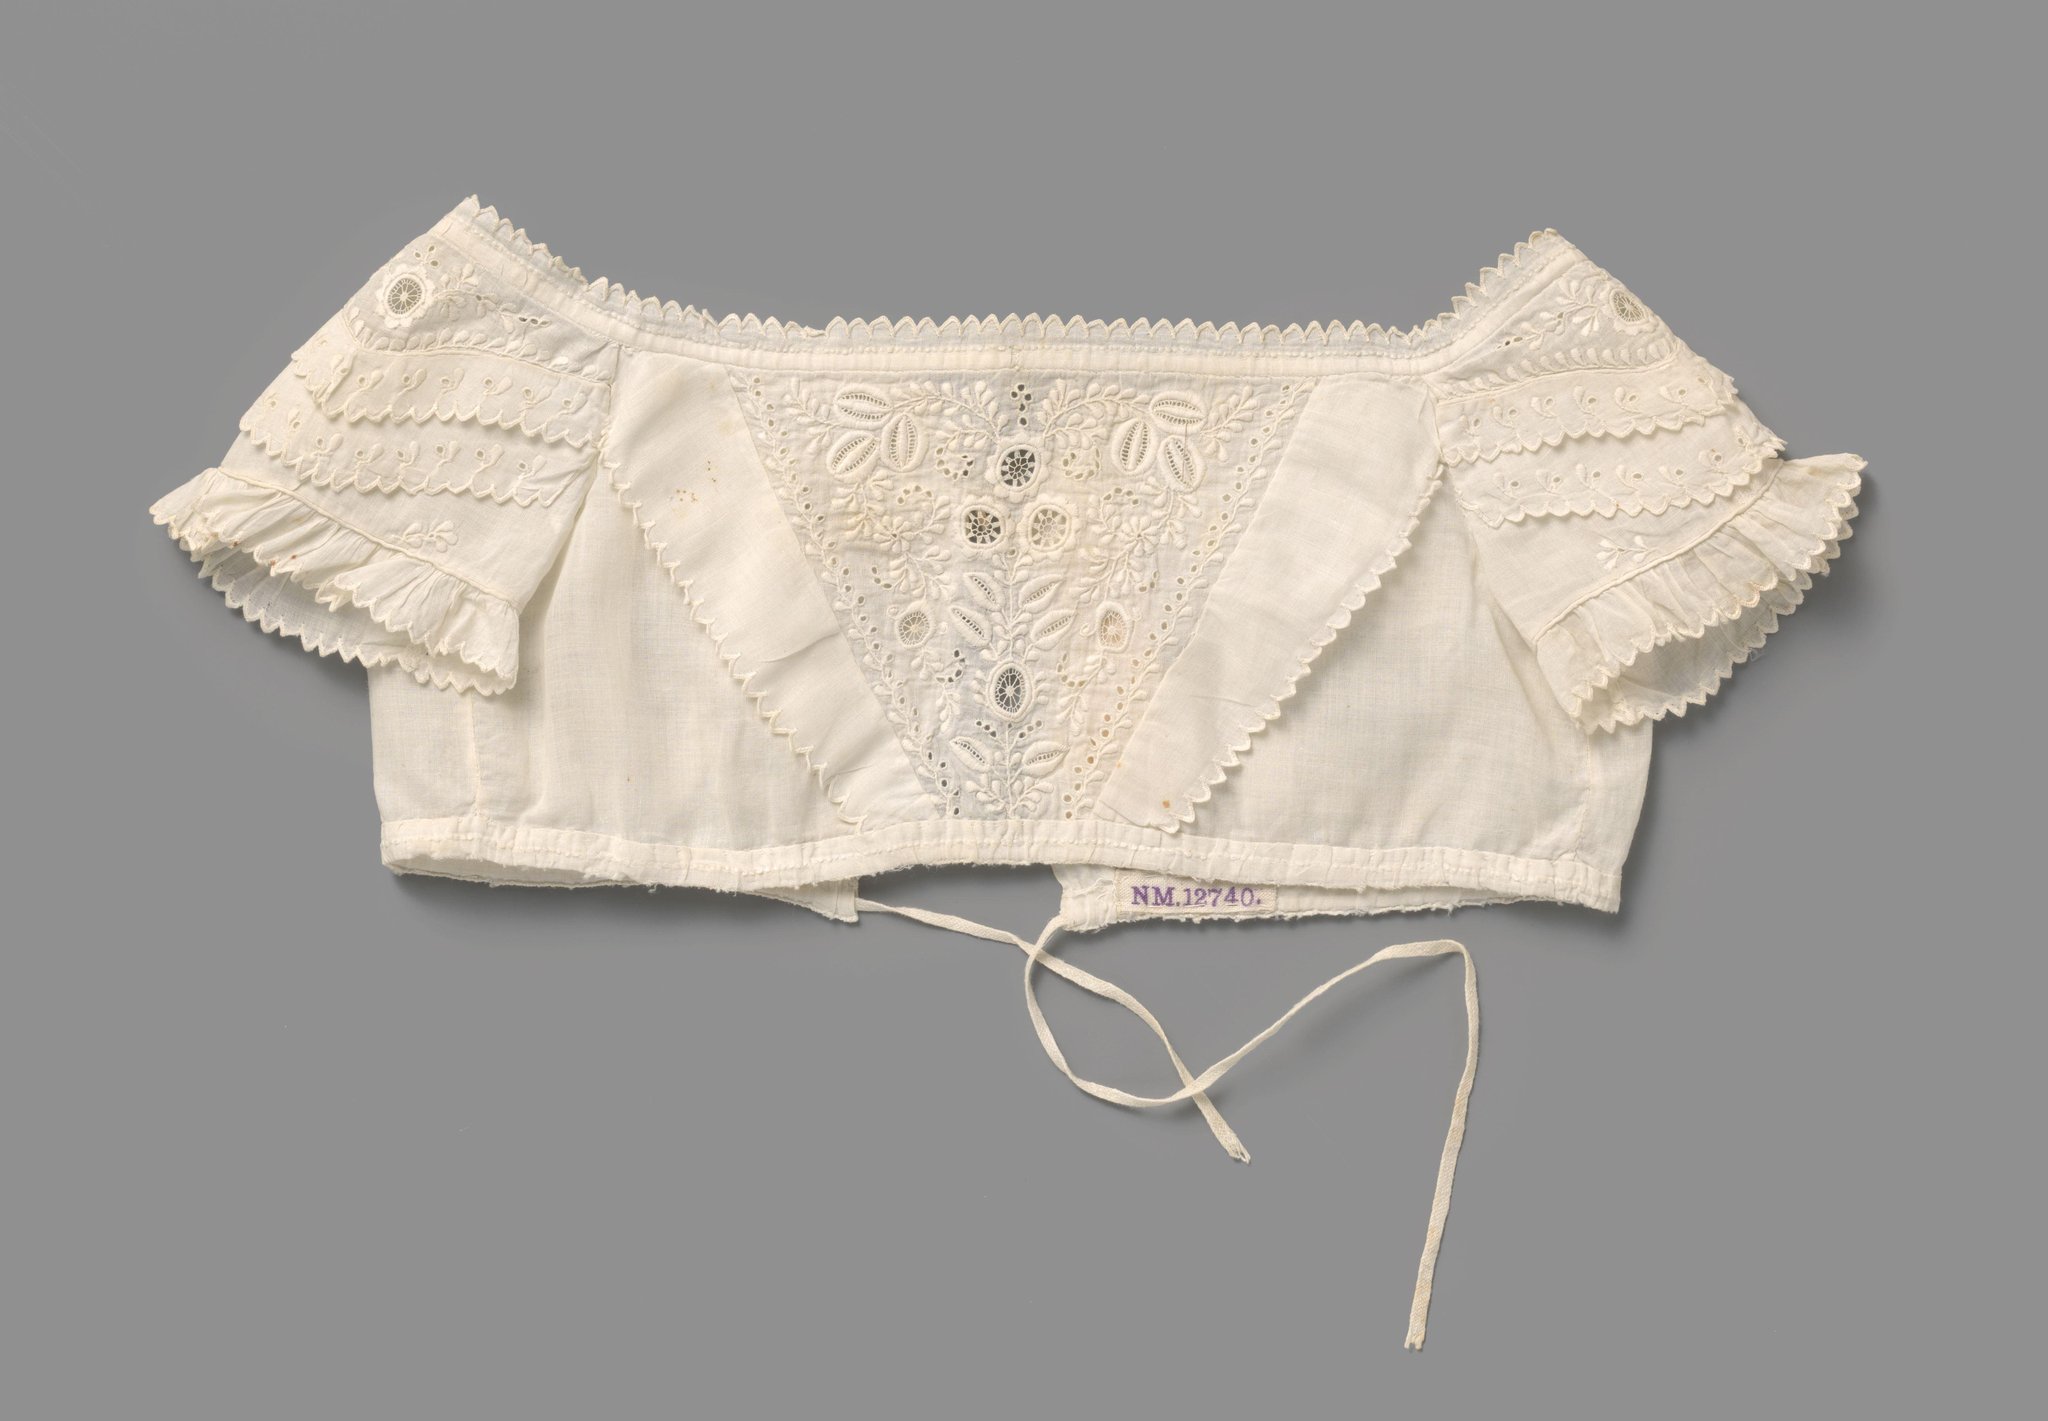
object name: clothing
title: Lijf van een witte katoenen kinderjurk, met trapeziumvormig voorstuk met bloem- en bladranken van Engels borduurwerk; afwerking met geschulpte gefestonneerde randen en ruches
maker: Anonymous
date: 1800-1915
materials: cotton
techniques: embroidered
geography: netherlands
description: Bovenstuk van een witkatoenen kinderjurk. Kort lijf met trapezium-vormig voorstuk, waarop in wit bloemen, bladeren en ranken geborduurd zijn. Langs de korte mouwen, de hals en het voorstuk met een festoen afgemaakt.